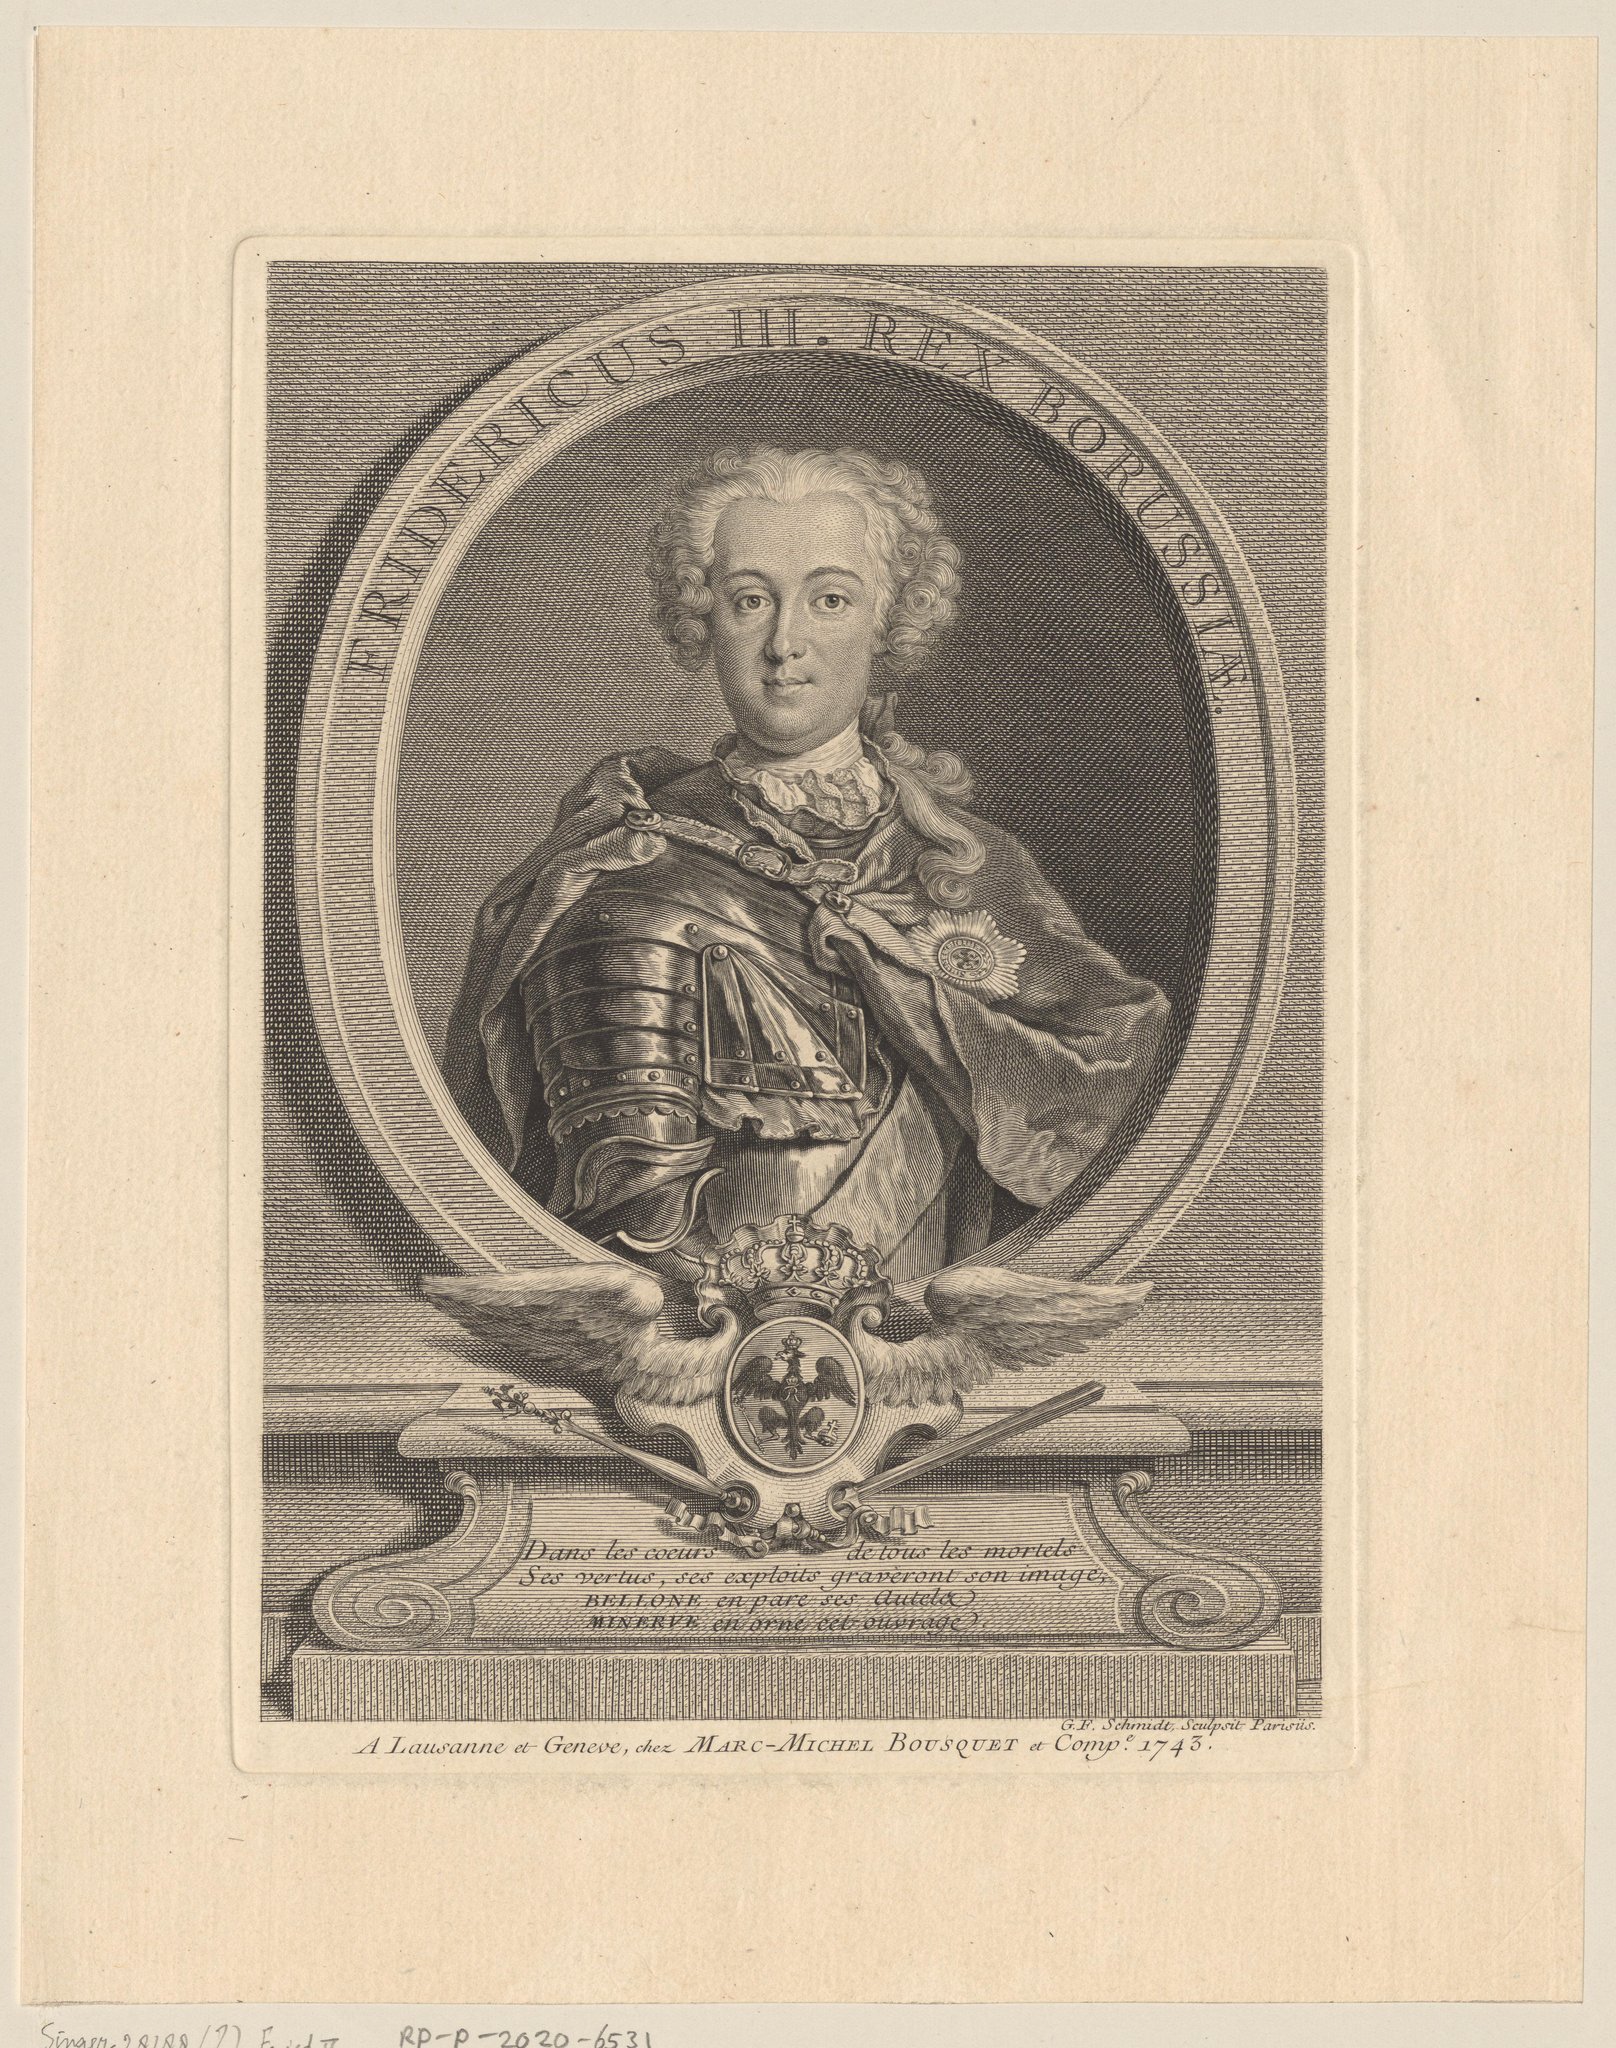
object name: print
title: Portret van Frederik de Grote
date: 1743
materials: paper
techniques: engraving, etching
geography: lausanne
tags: berlin, frederick ii (king of prussia), coat of arms (symbol of sovereignty), ornament ~ medallion, armour, historical persons, king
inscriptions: collector's mark: Lugt 240